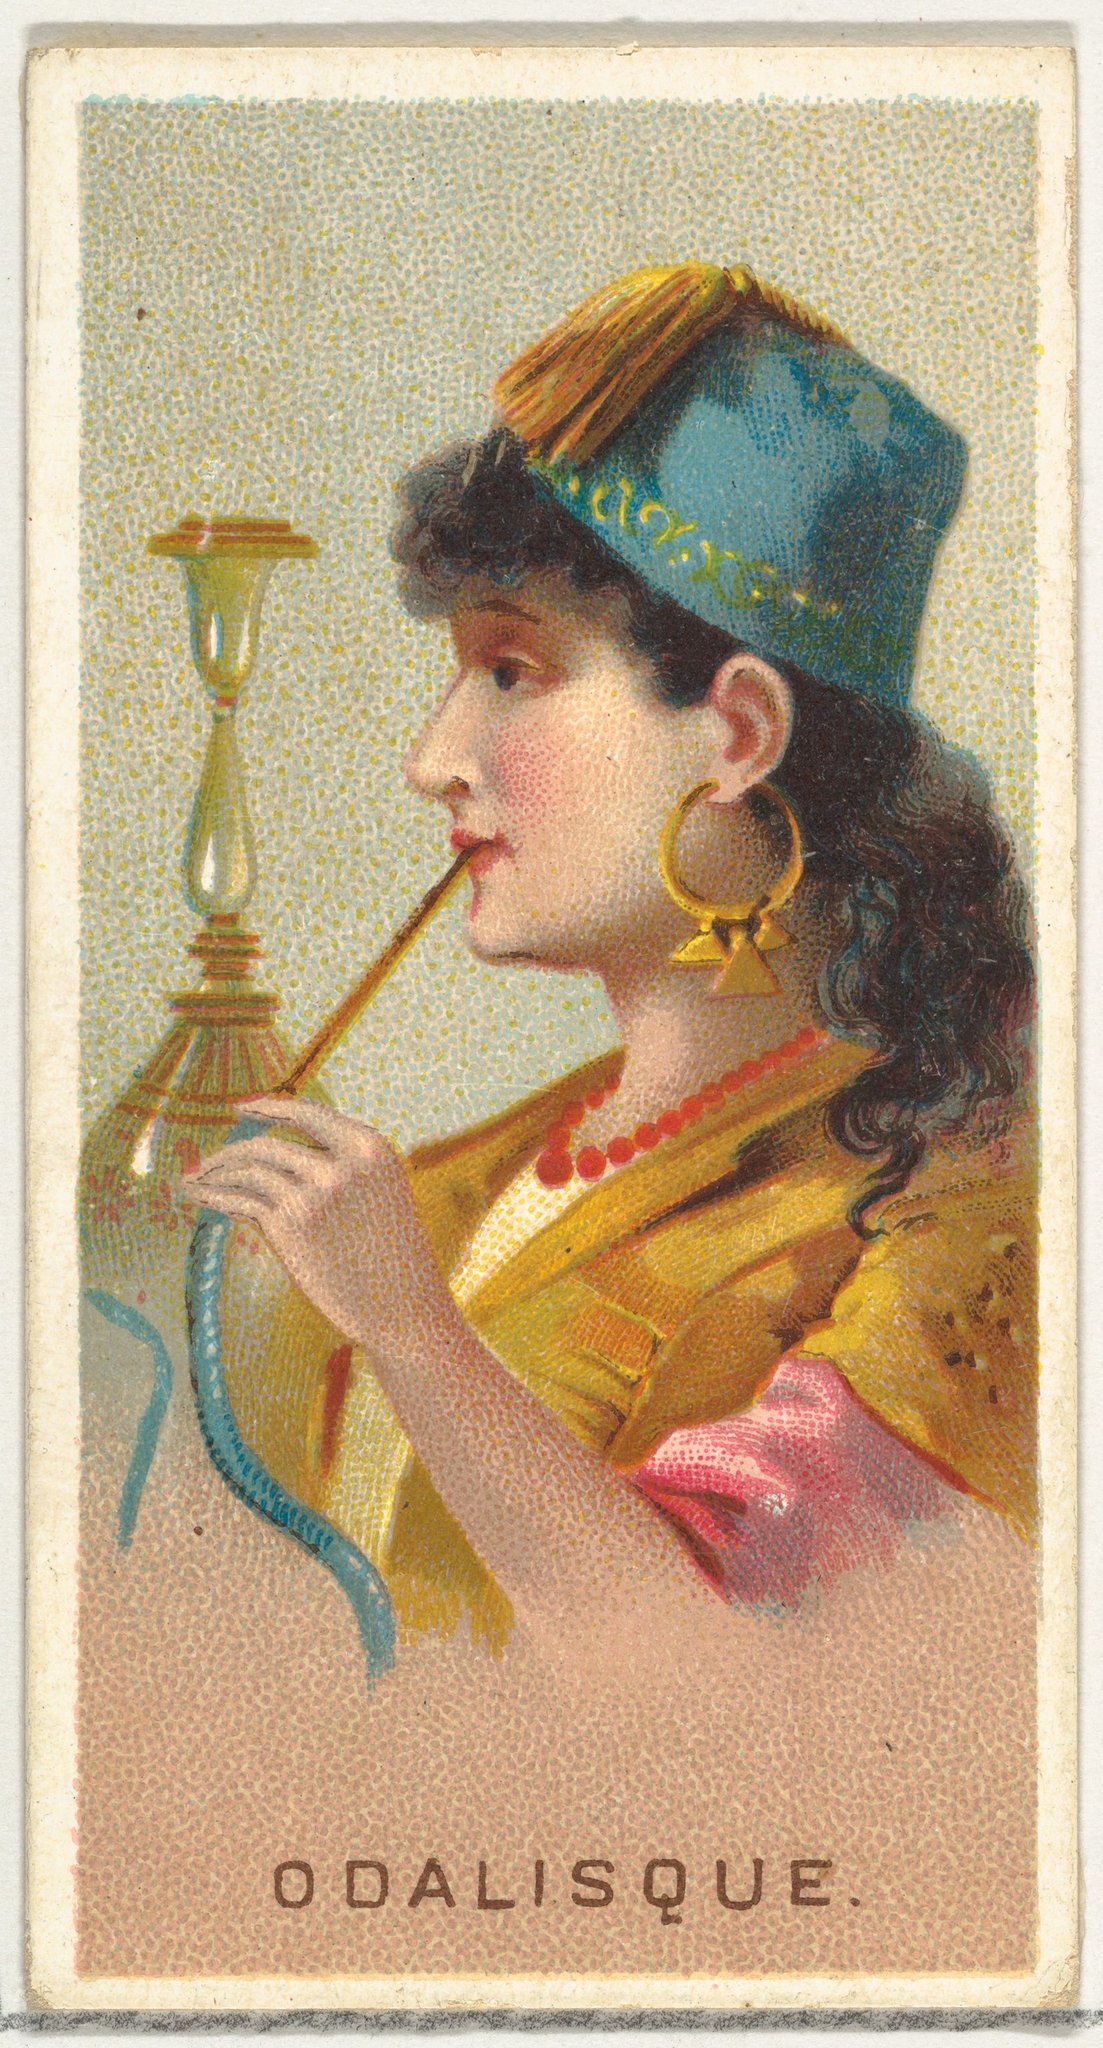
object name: print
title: Odalisque, from World's Smokers series (N33) for Allen & Ginter Cigarettes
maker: allen & ginter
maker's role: publisher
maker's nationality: american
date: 1888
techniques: color lithograph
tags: profiles,women,smoking